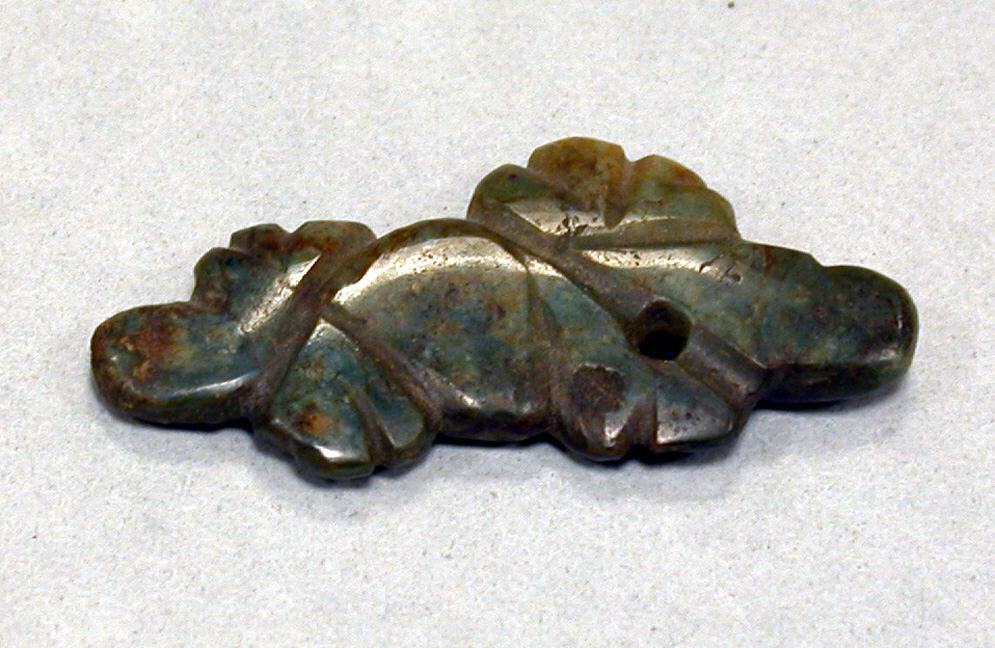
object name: pendant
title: Stone Animal Pendant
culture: costa rican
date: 801-1500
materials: stone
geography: costa rica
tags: animals